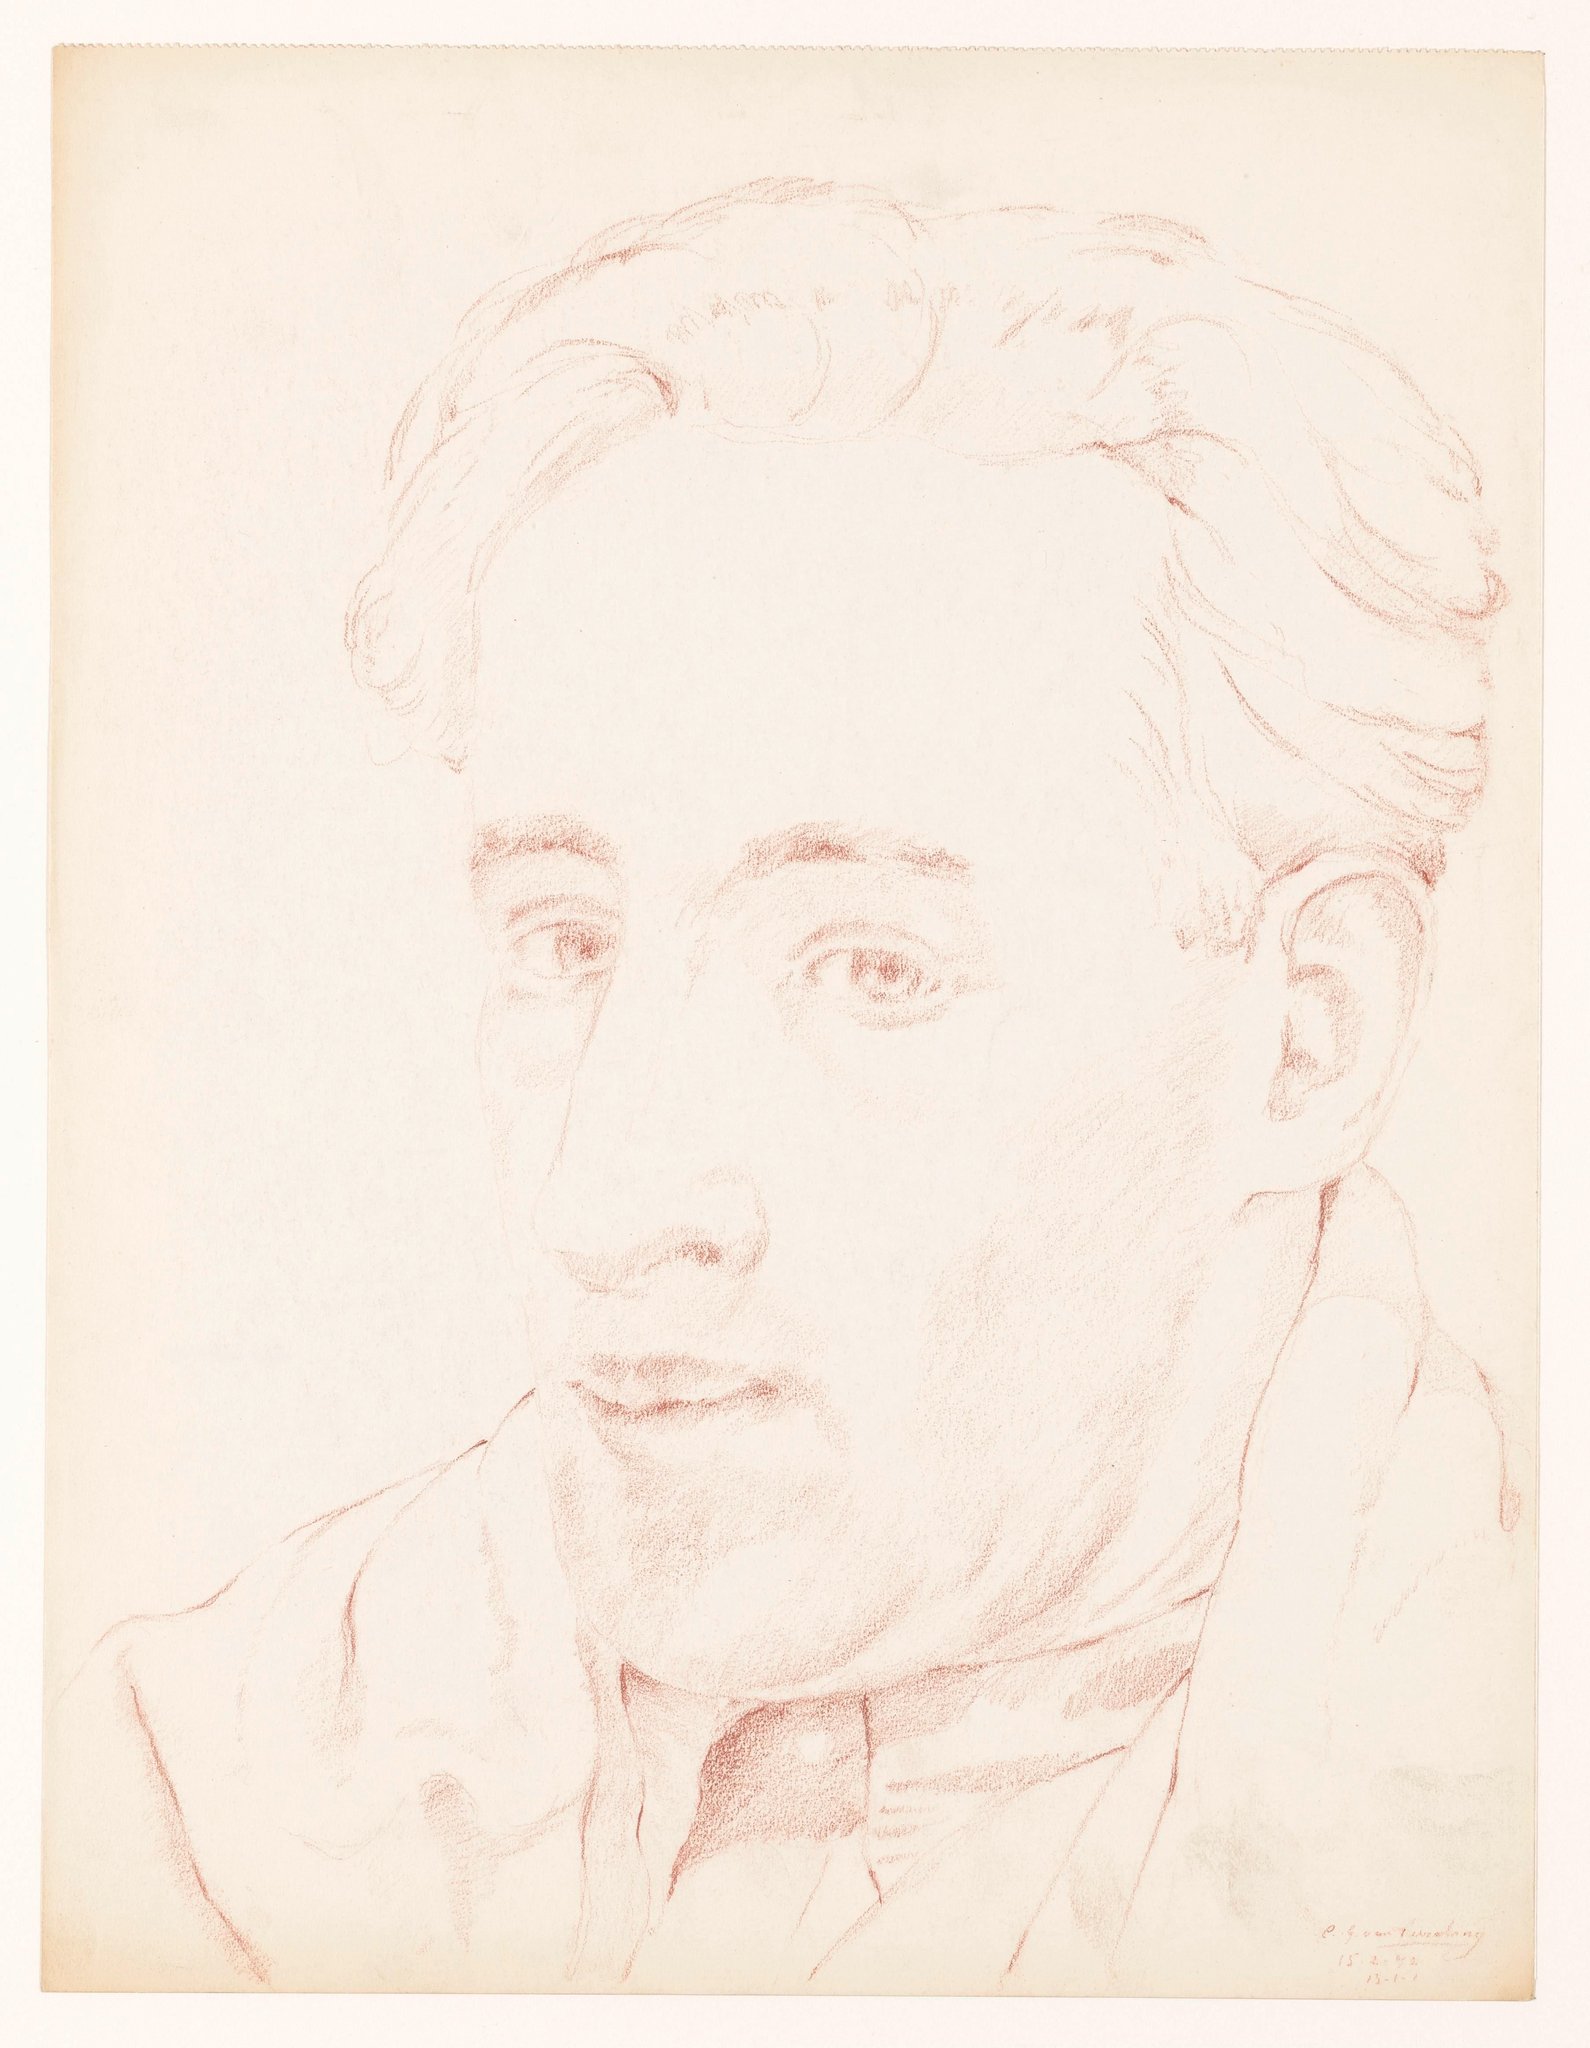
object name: drawing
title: Zelfportret: B-1-1, 15 februari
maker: cor van teeseling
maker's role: draughtsman, sculptor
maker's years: 1915-1942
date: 1942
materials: paper, pencil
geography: weteringschans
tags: amsterdam, draughtsman, sculptor, cor van teeseling, historical persons, prisoner in cell or locked place, portrait, self-portrait of draughtsman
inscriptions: date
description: Zelfportret van Cor van Teeseling: B-1-1, 15 februari. Getekend zelfportret van Cor van Teeseling driekwart naar links kijkend.